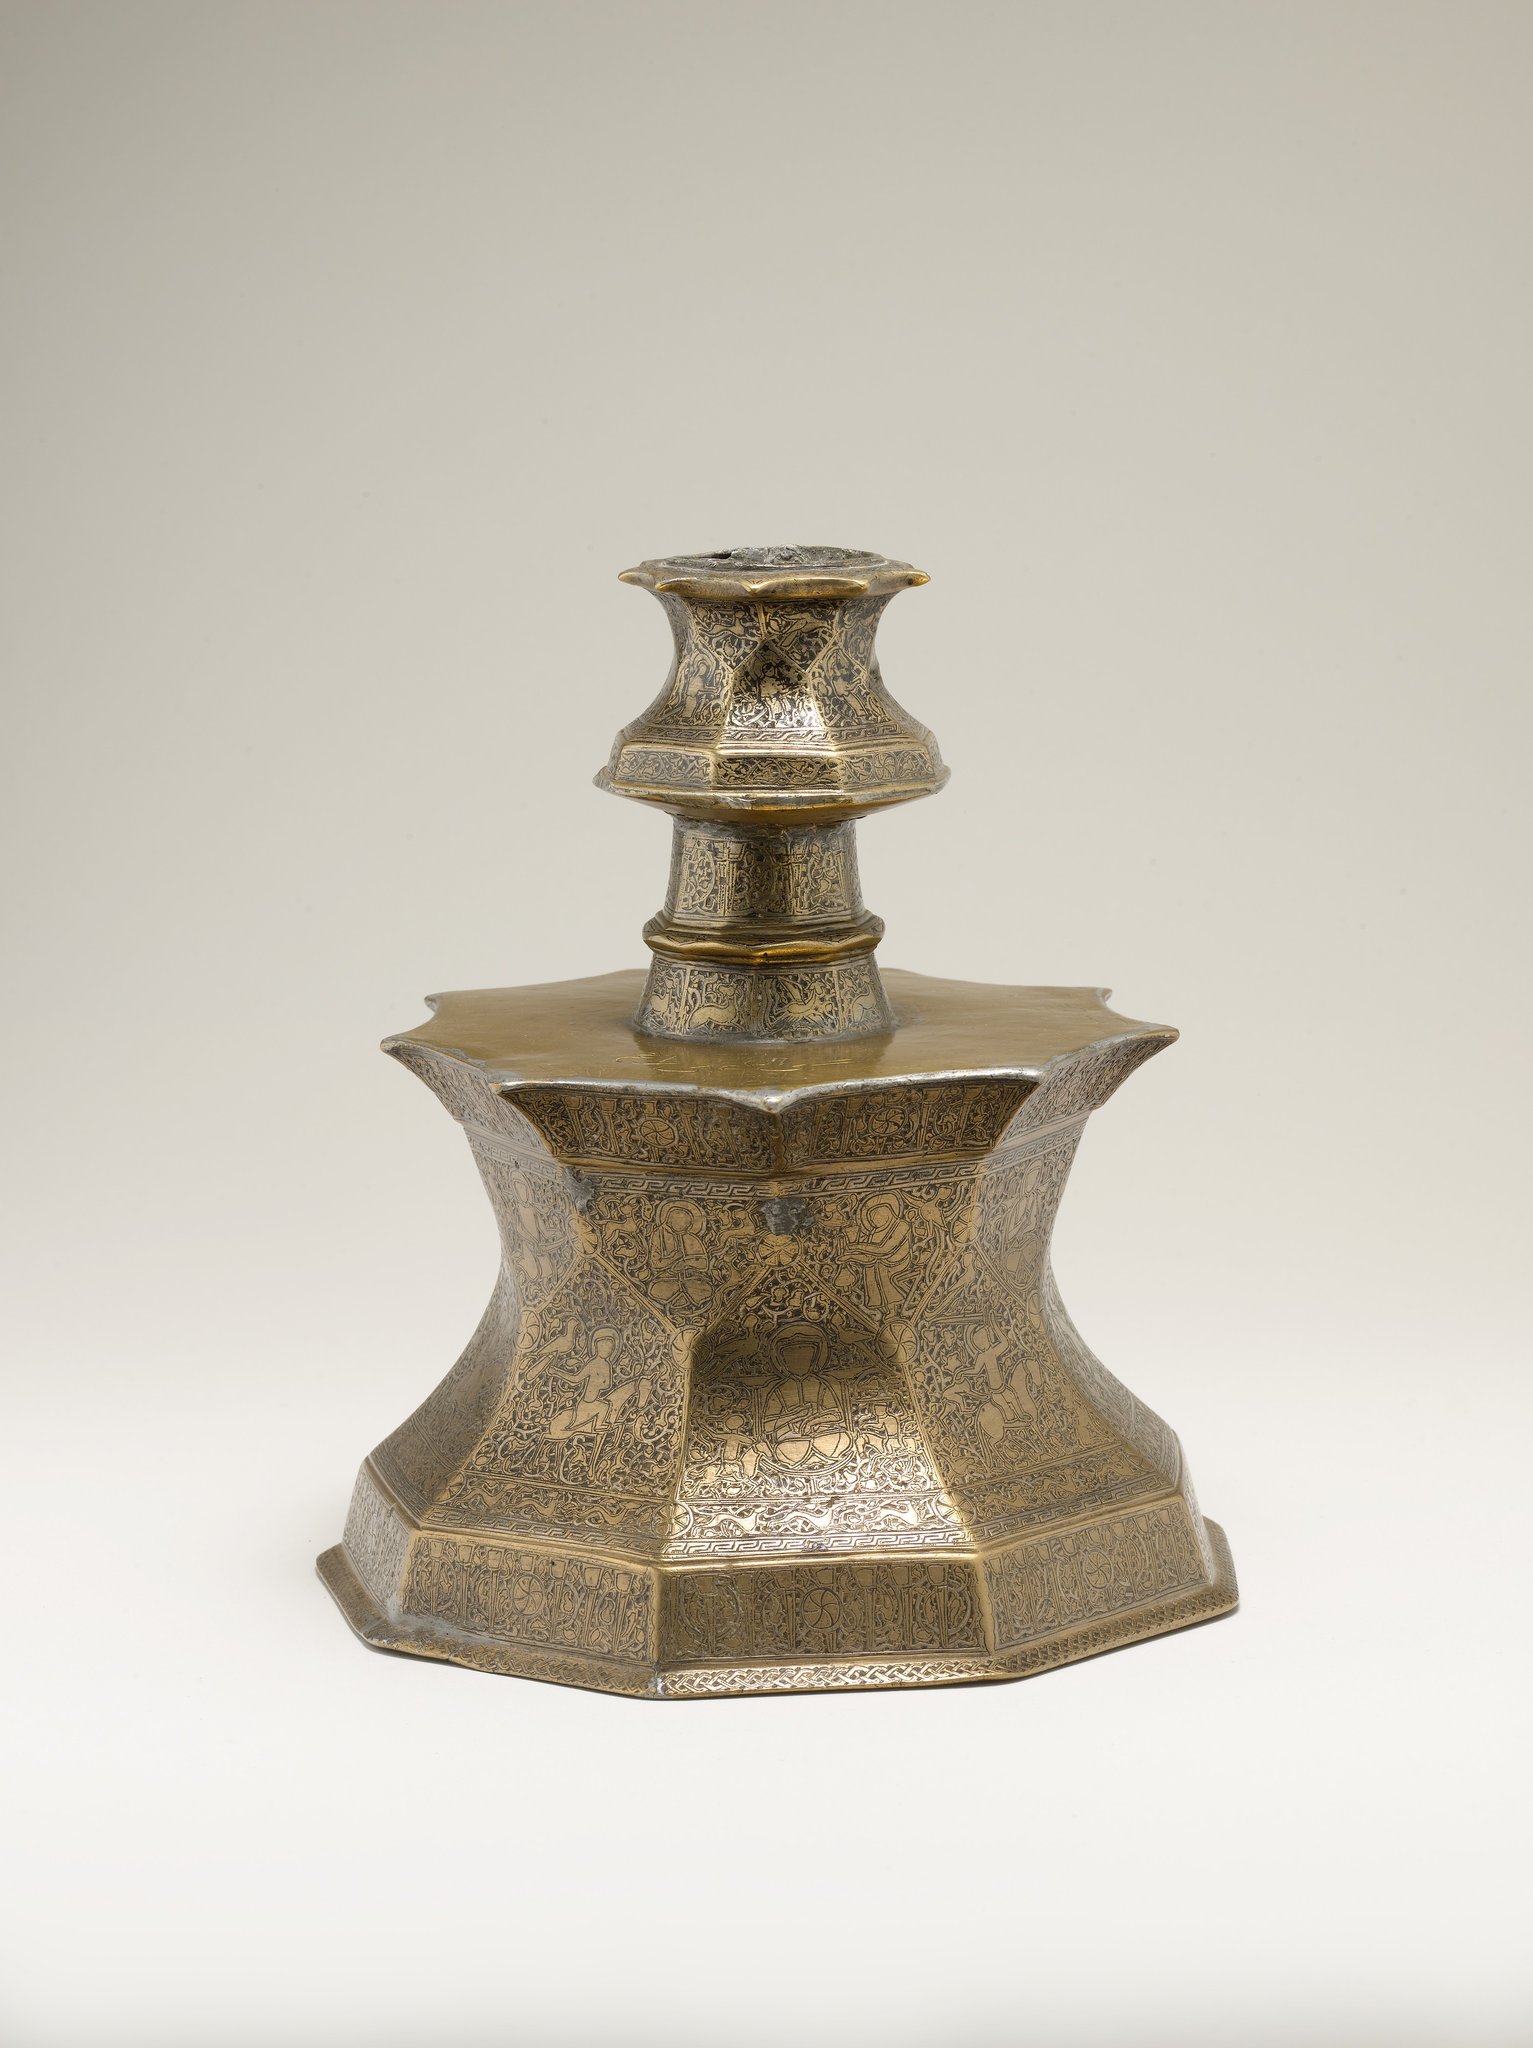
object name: candlestick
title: Candlestick with Figural Imagery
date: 1301-1350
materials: brass, silver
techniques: casting, engraving, inlay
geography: iran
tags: goats,horses